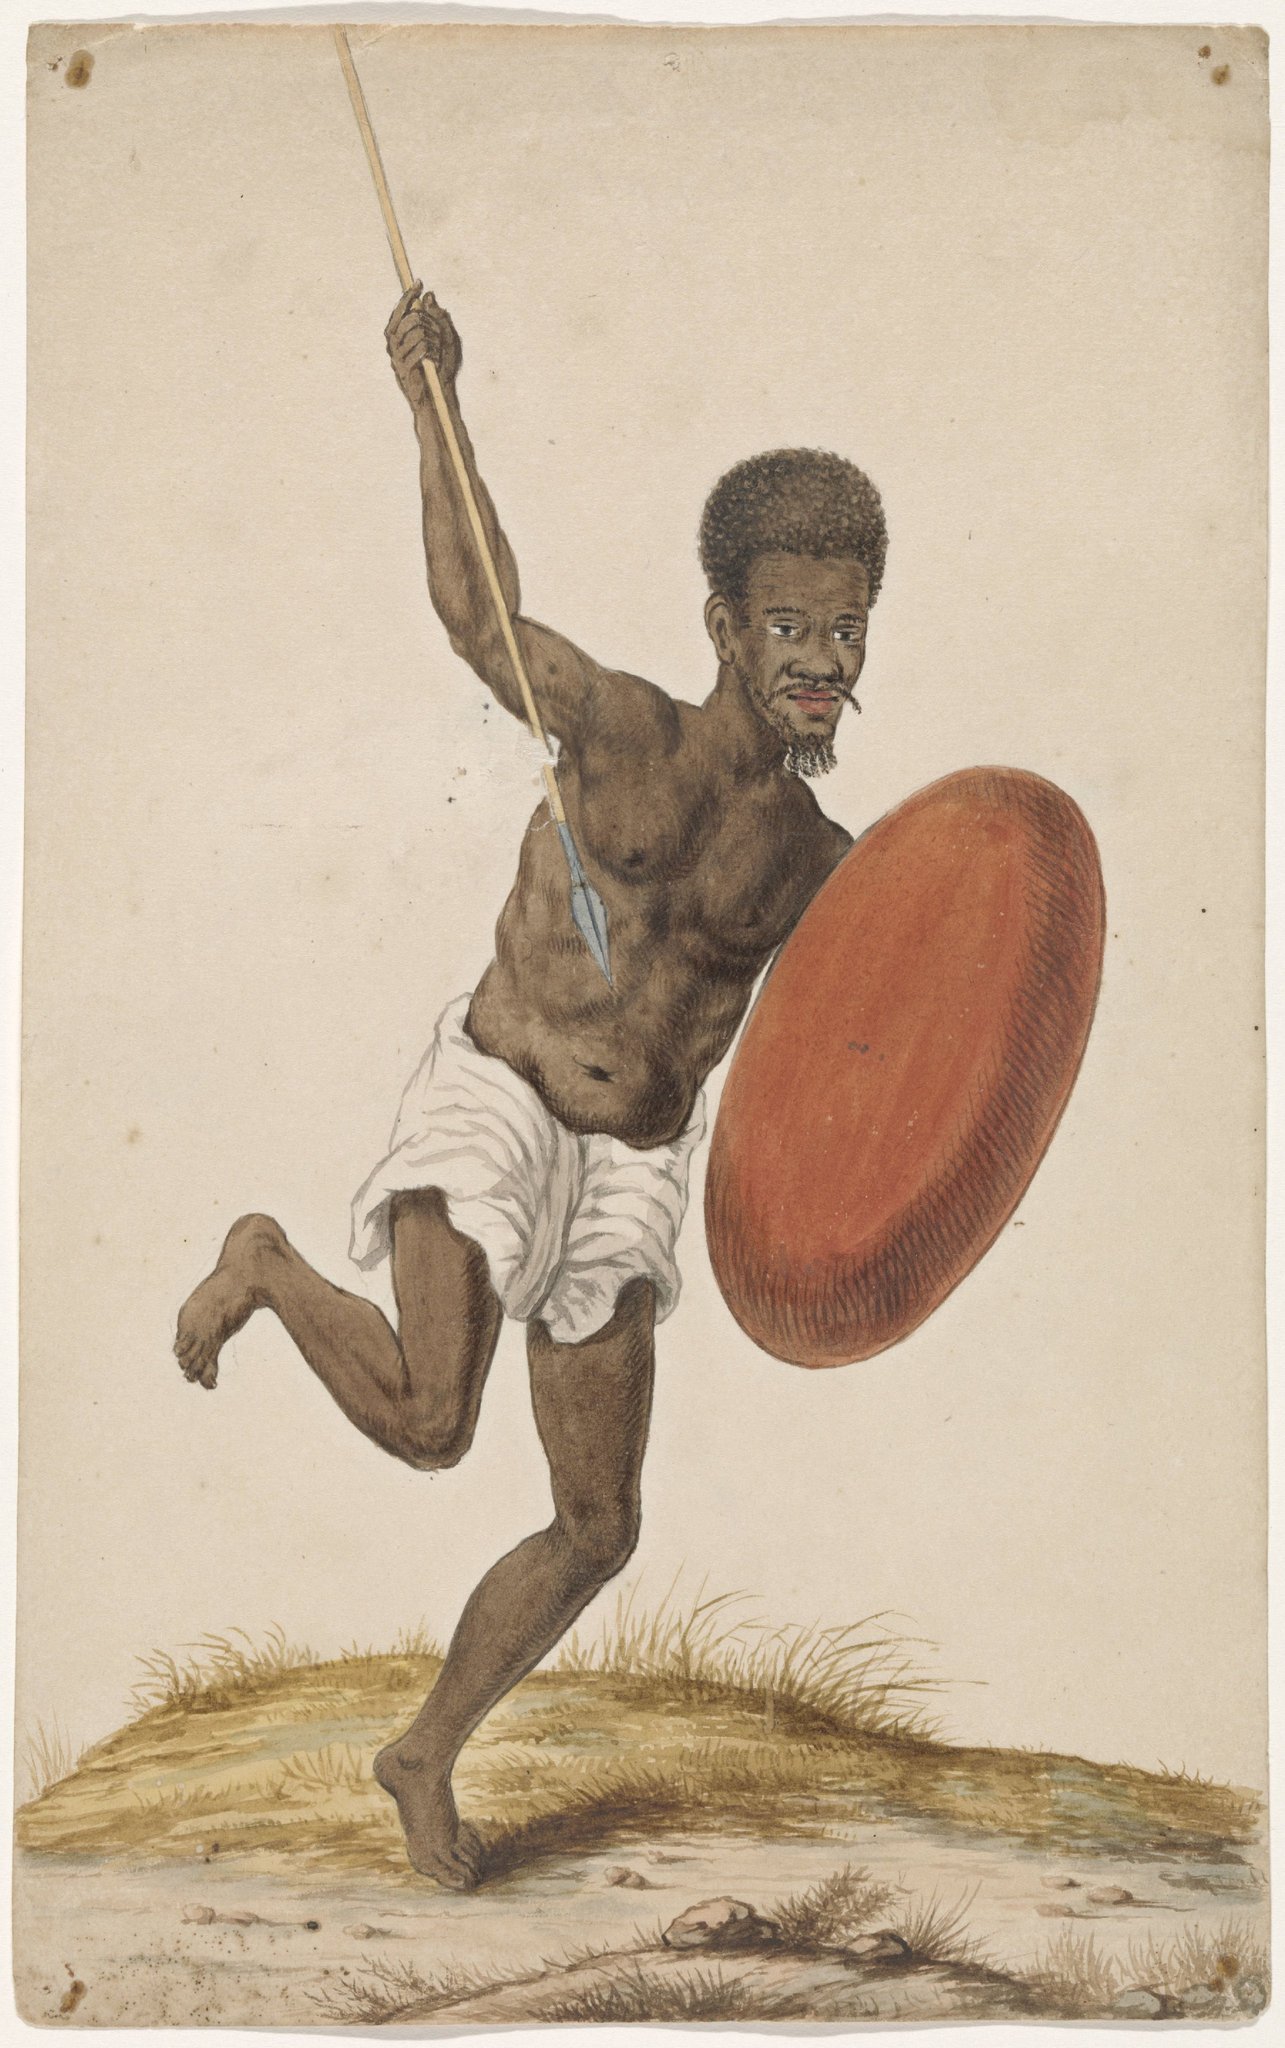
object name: drawing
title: A Malagasy Warrior with (1628-1664)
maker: Anonymous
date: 1675-1725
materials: paper, watercolor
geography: netherlands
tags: africans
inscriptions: annotation: ‘Koning van de Baij Antonghis op 't Eijland Madagascar’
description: Andries Beeckman (1628-1664). Andries Beeckman recorded the people he saw on his travels to South Africa and Southeast Asia. As far as we know he drew them from life. Only he probably did not see the Khoikhoi woman with an infant in this way, as he copied her from a drawing in an English travel journal. Beeckman’s drawings found favour with European collectors and he also used them as preliminary studies for his paintings.